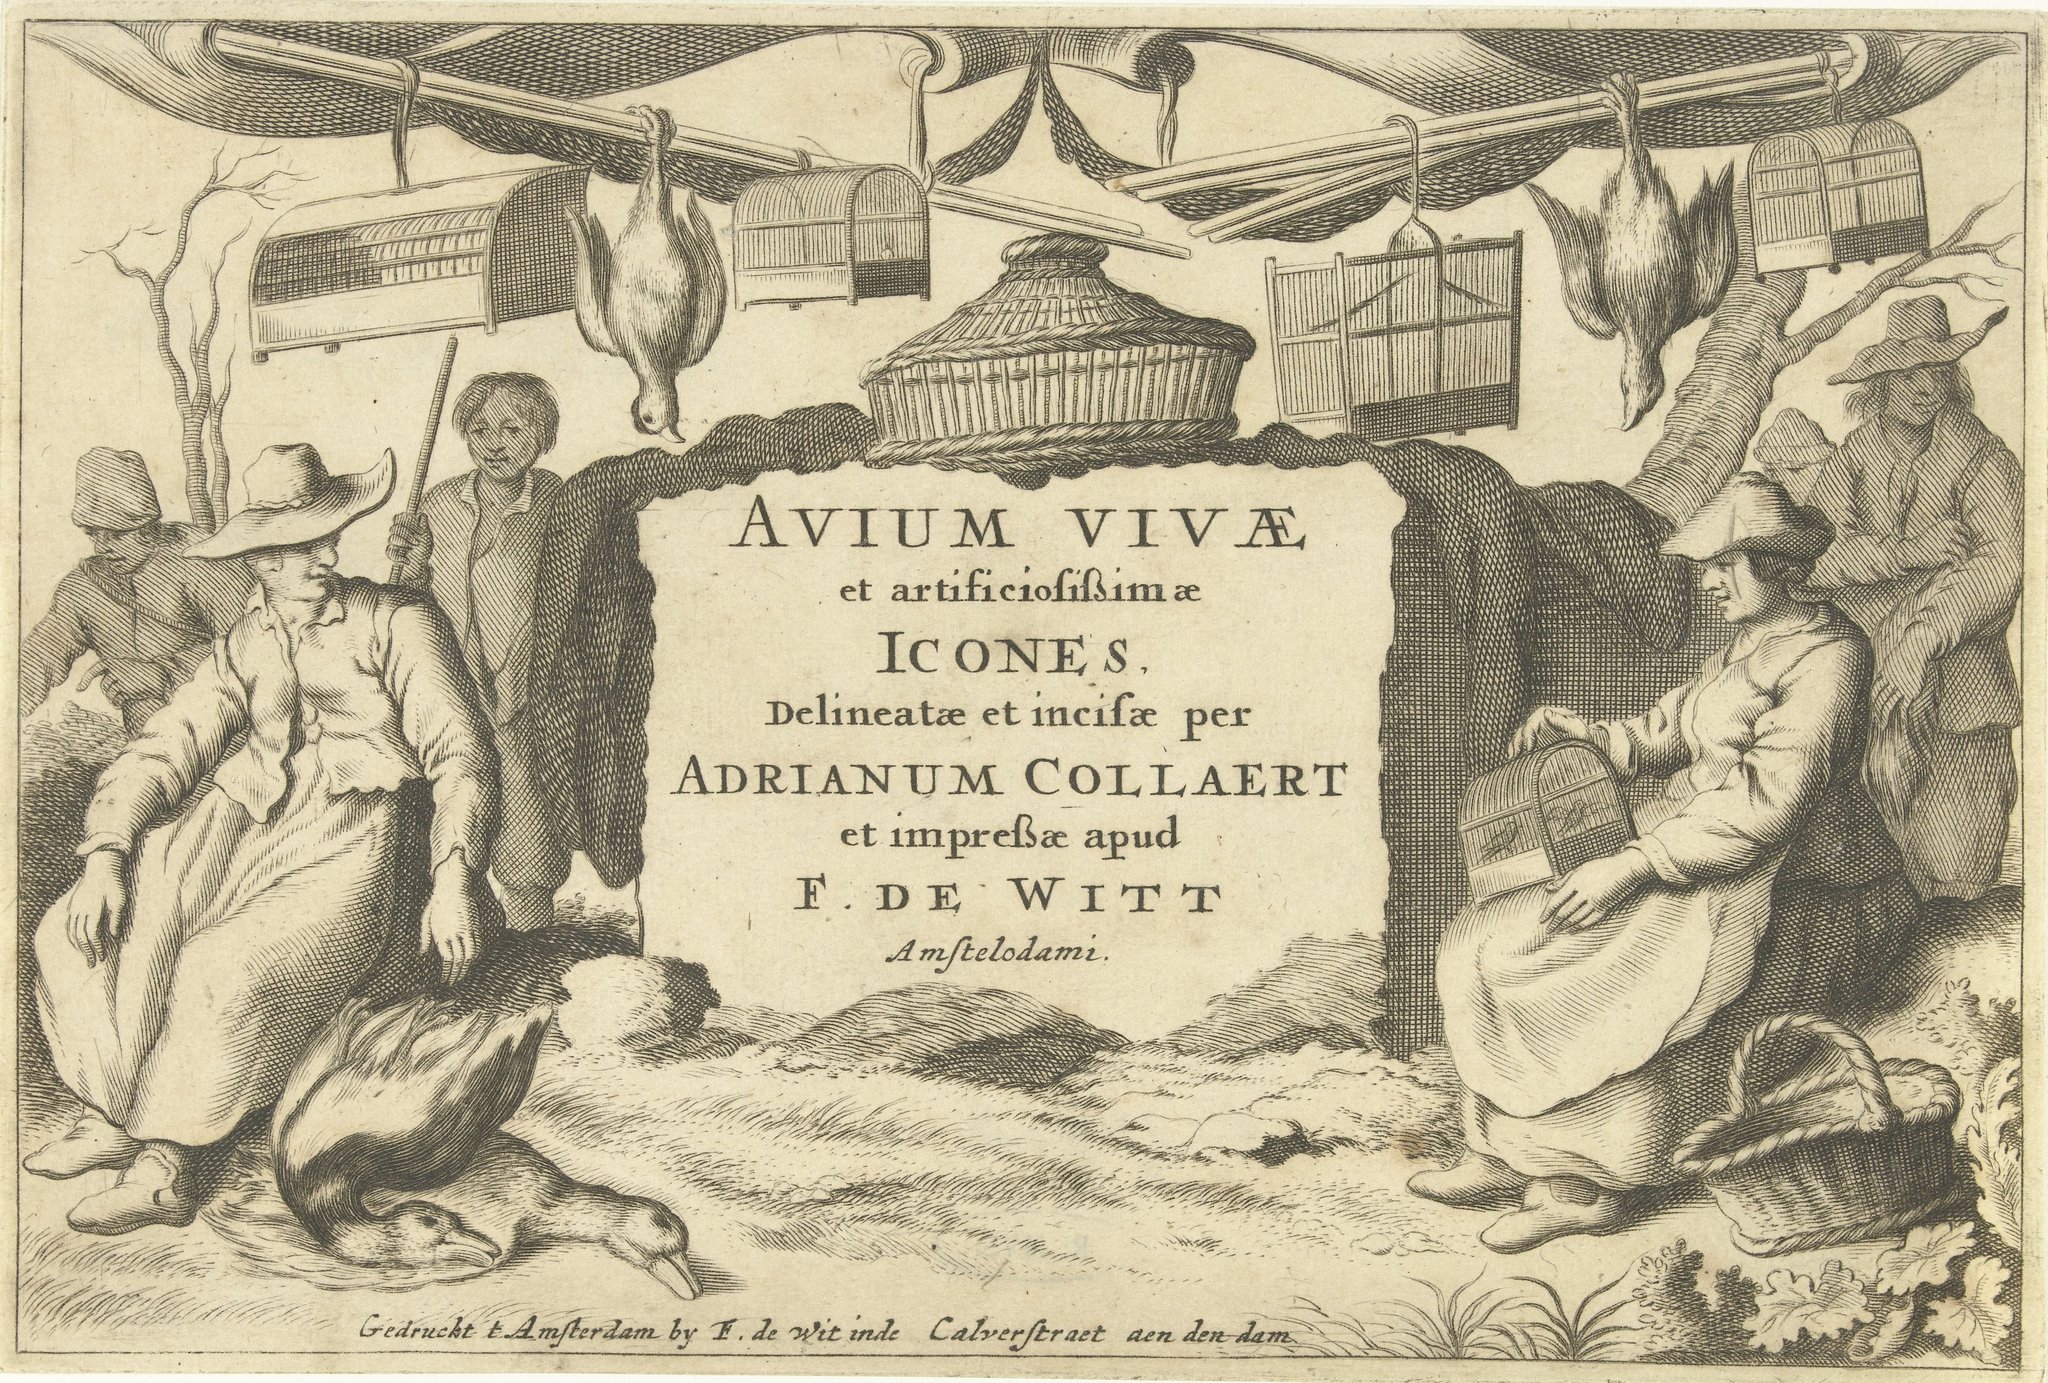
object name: print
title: Vogels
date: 1659-1706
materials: paper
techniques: engraving, etching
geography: amsterdam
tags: fowling, fowler, bird in a cage, birds (+ animal(s) being hit, shot, caught), water-birds: duck (+ dying animal; death of animal; dead animal)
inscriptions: collector's mark: Lugt 2228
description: Centraal de Latijnse titel van de serie en de naam van de ontwerper en de uitgever. Rondom de titel vogelvangers en vogelverkopers. Links zit een vrouw met naast haar twee dode eenden. Rechts zit een vrouw met een vogelkooi in de handen. Deze prent is de titelprent van een serie over vogels.